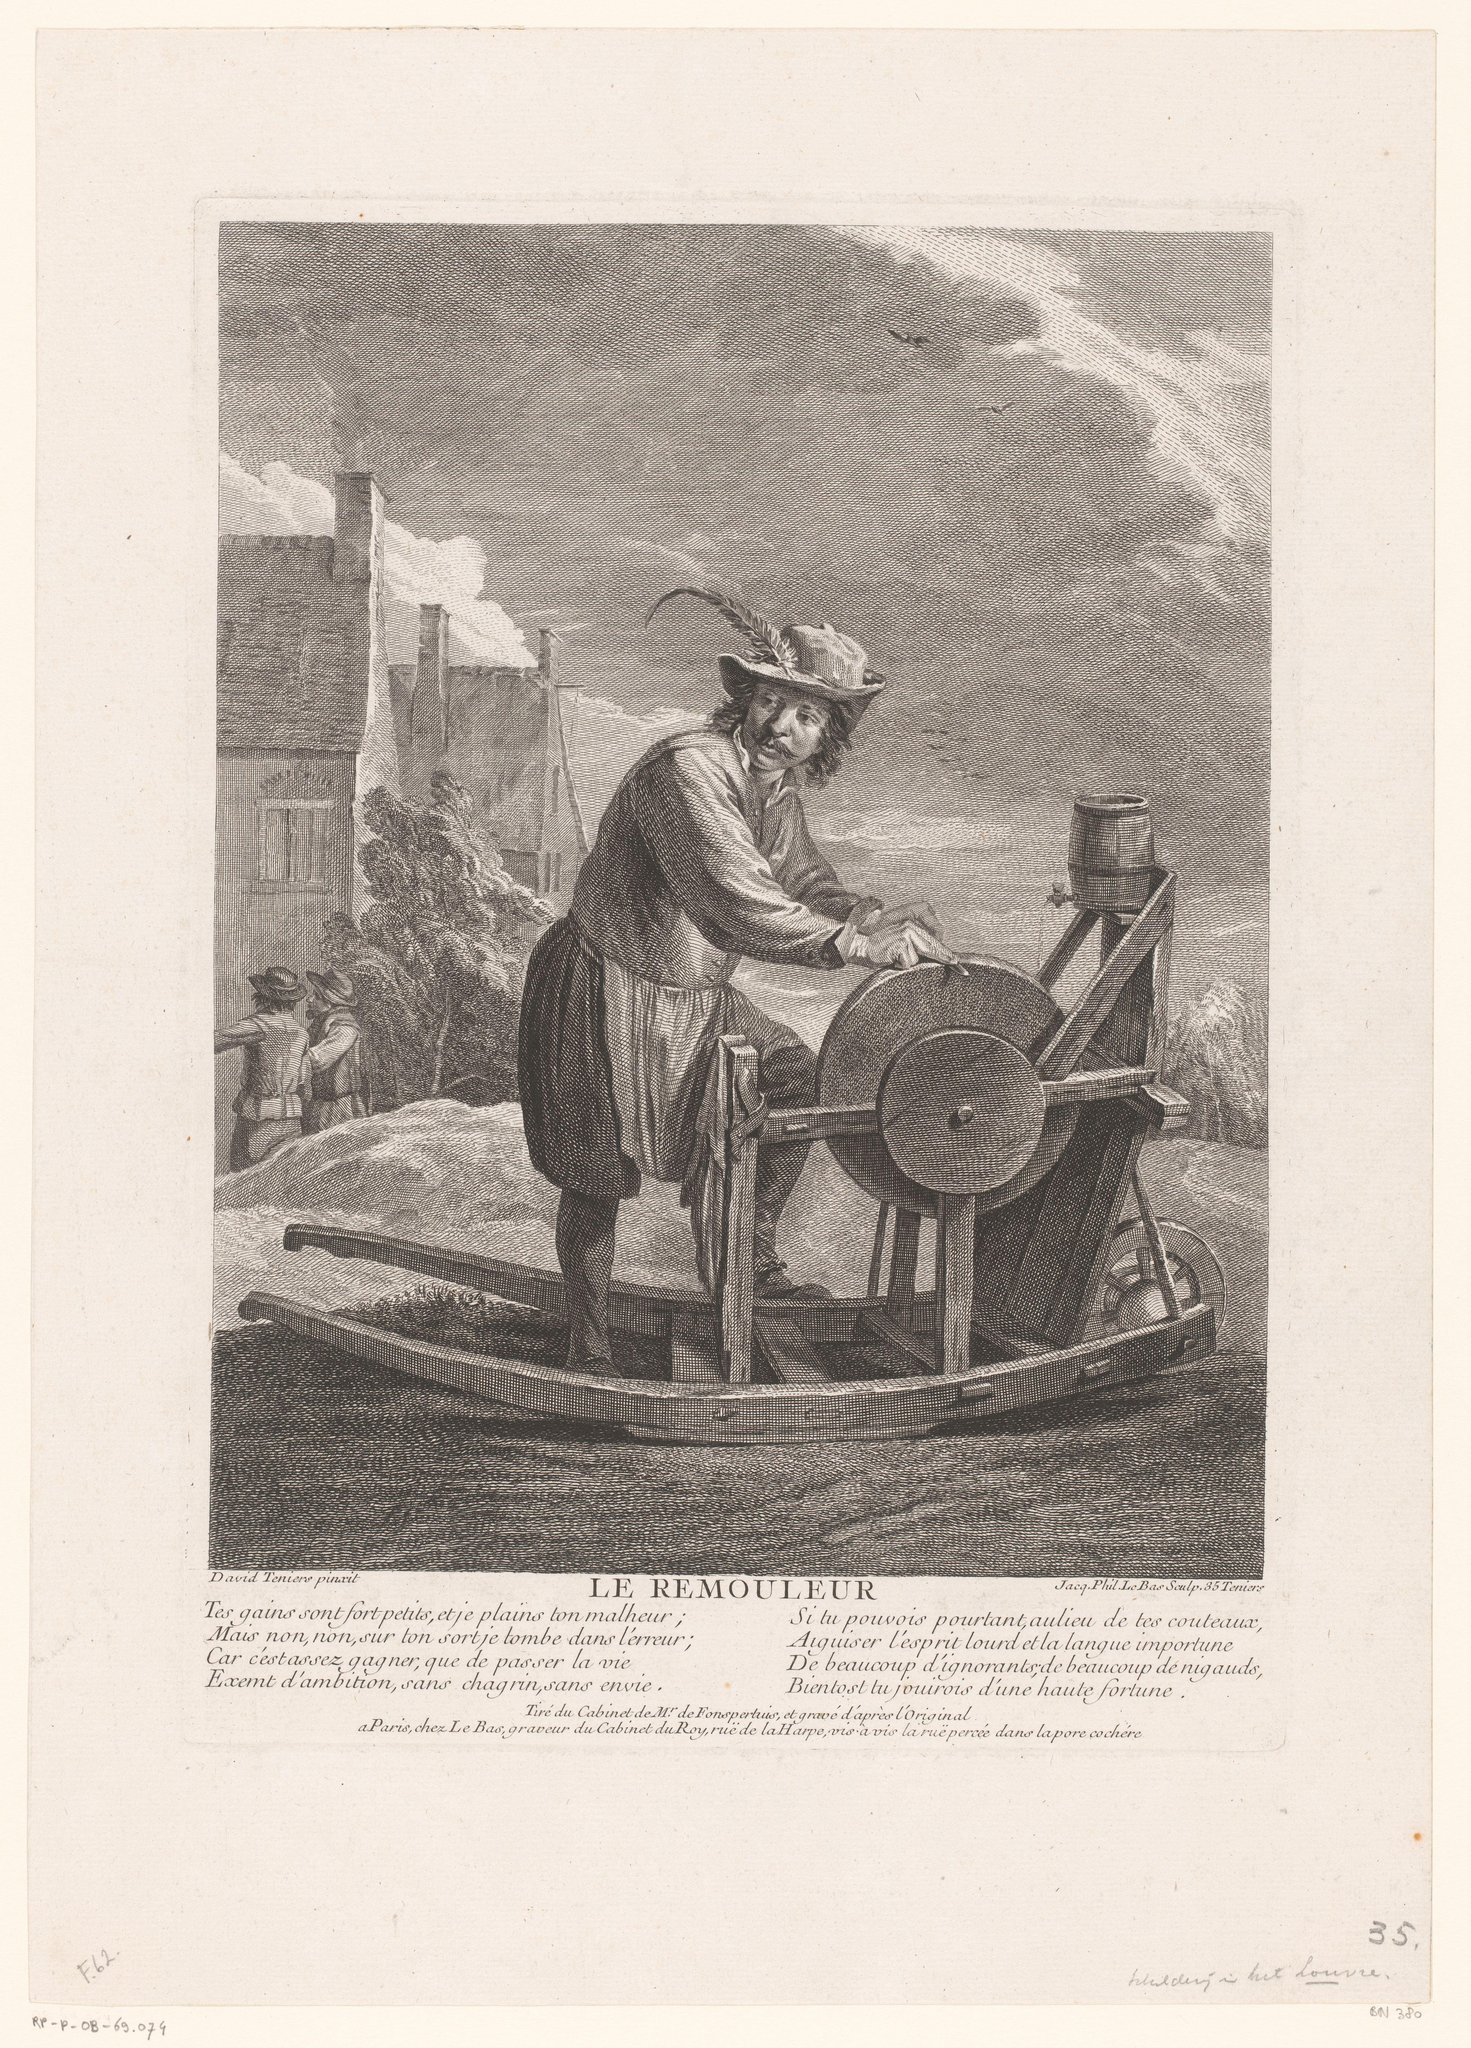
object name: print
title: Scharenslijper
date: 1717-1783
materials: paper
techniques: engraving, etching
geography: paris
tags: sharpening, grinding (industrial processes), handicrafts ~ maintenance and repair, tools, aids, implements ~ crafts and industries: grindstone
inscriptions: collector's mark: Lugt 240